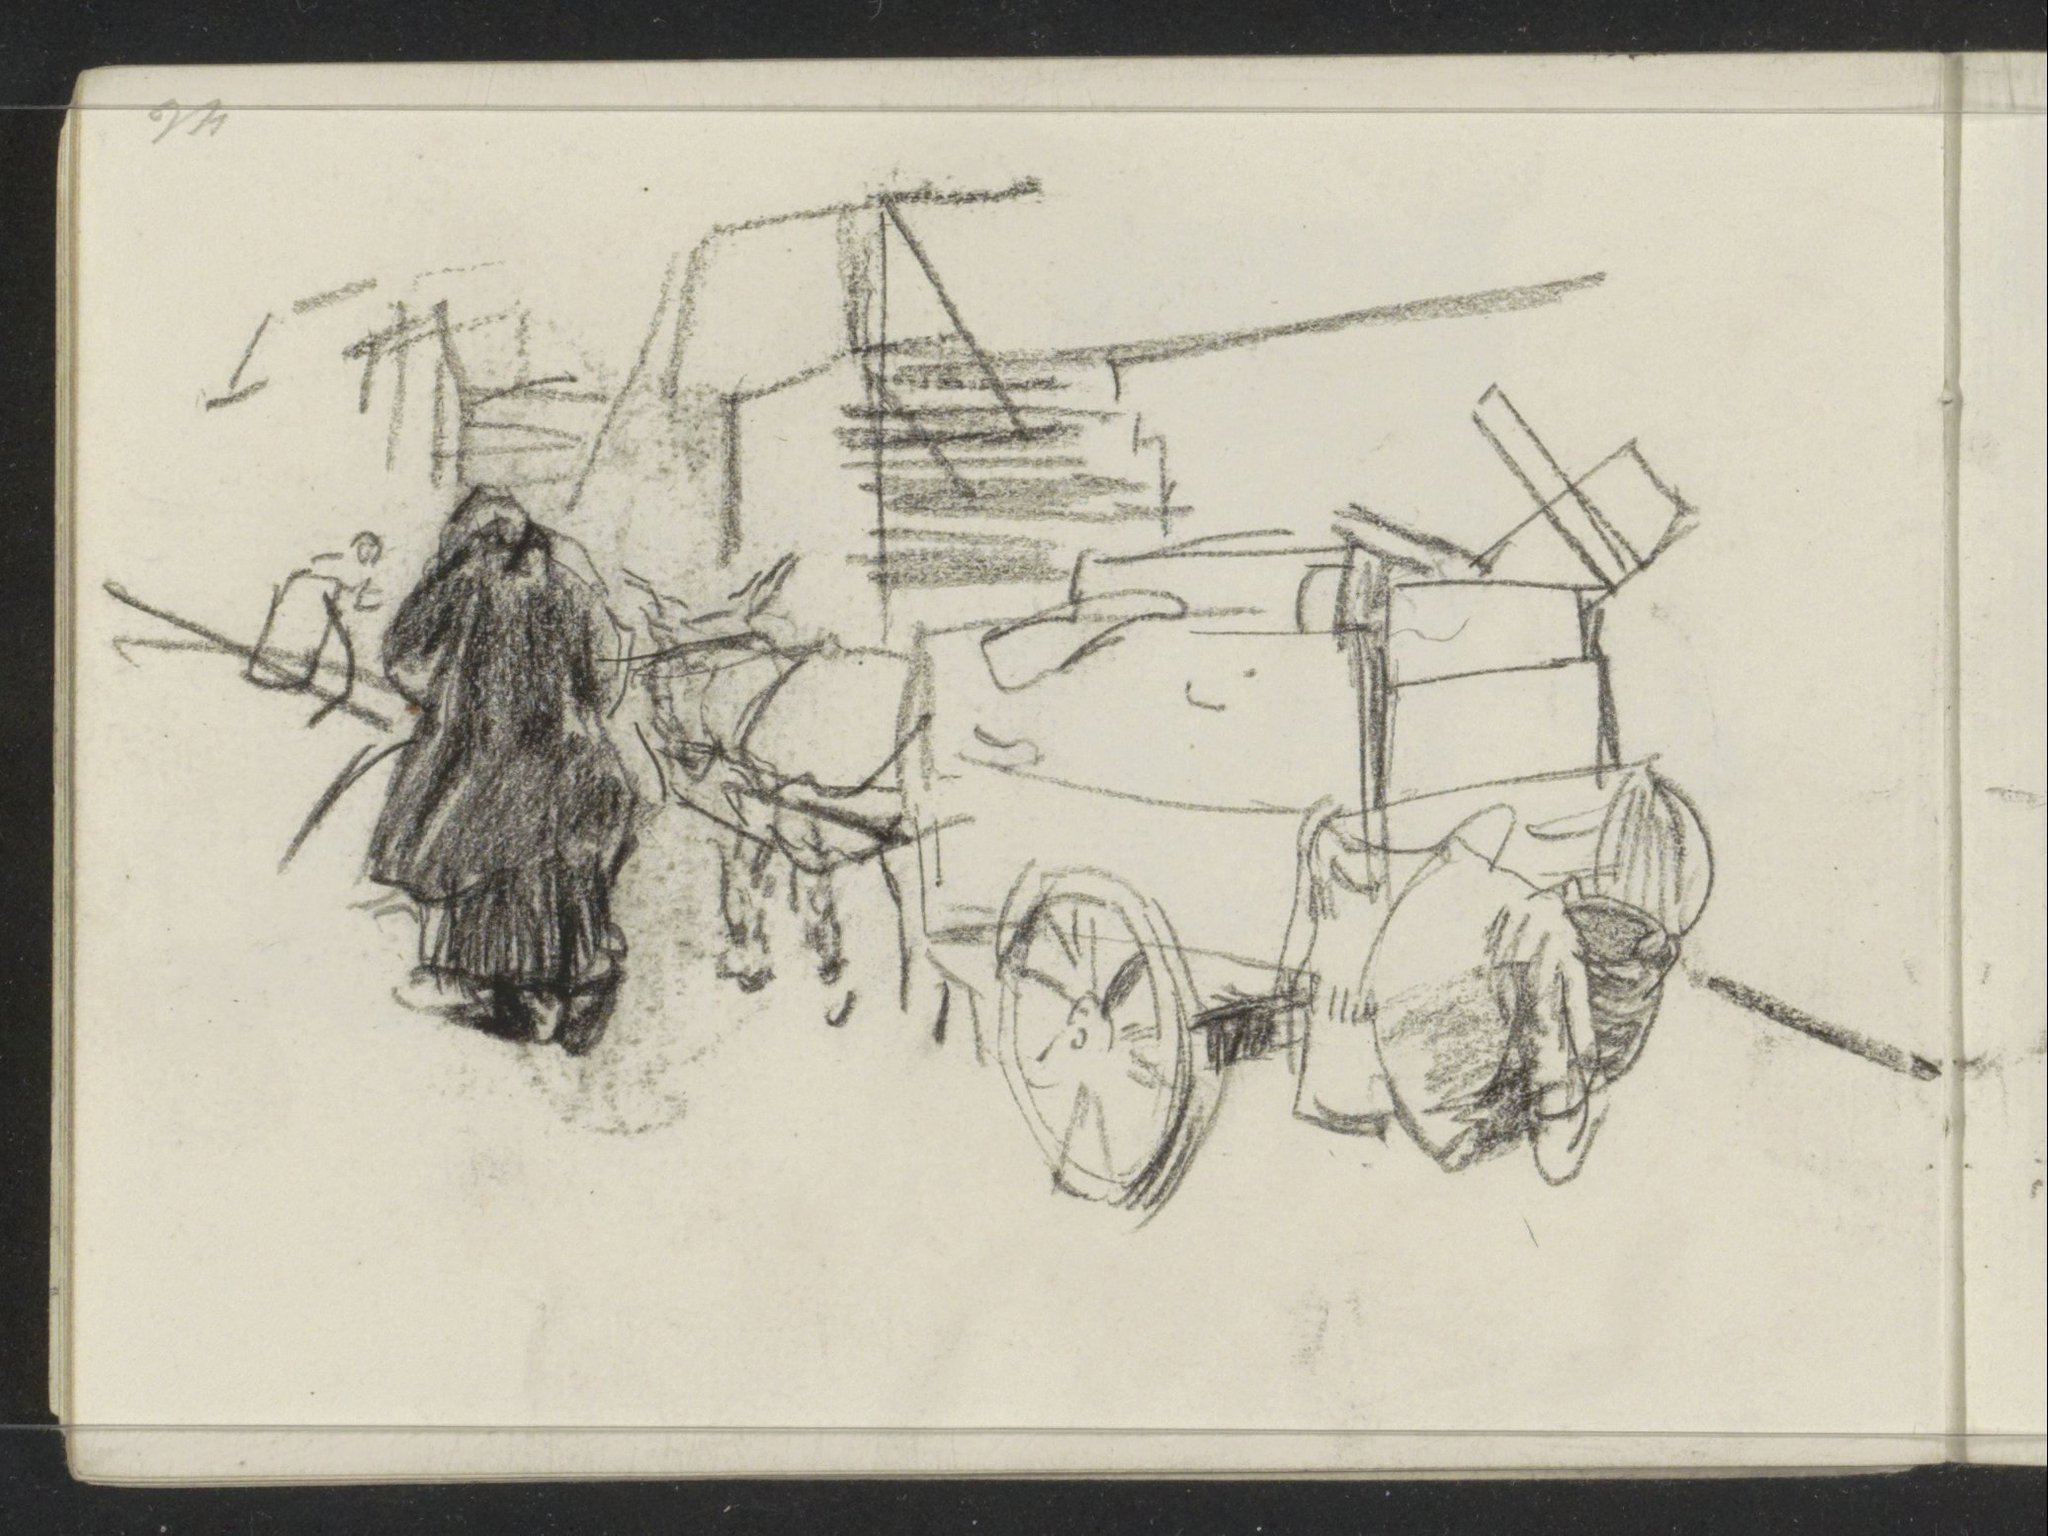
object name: sketchbook leaf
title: Vrouw bij een ezelkar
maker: isaac israels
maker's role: draughtsman, painter, print maker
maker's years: 1865-1934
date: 1886-1934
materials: chalk, paper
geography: amsterdam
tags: adult woman, ass, donkey, two-wheeled vehicle drawn by one animal, street (+ city(-scape) with figures, staffage)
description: De kar staat voor een geveltrap. Blad 13 verso uit schetsboek LXIV met 29 bladen.